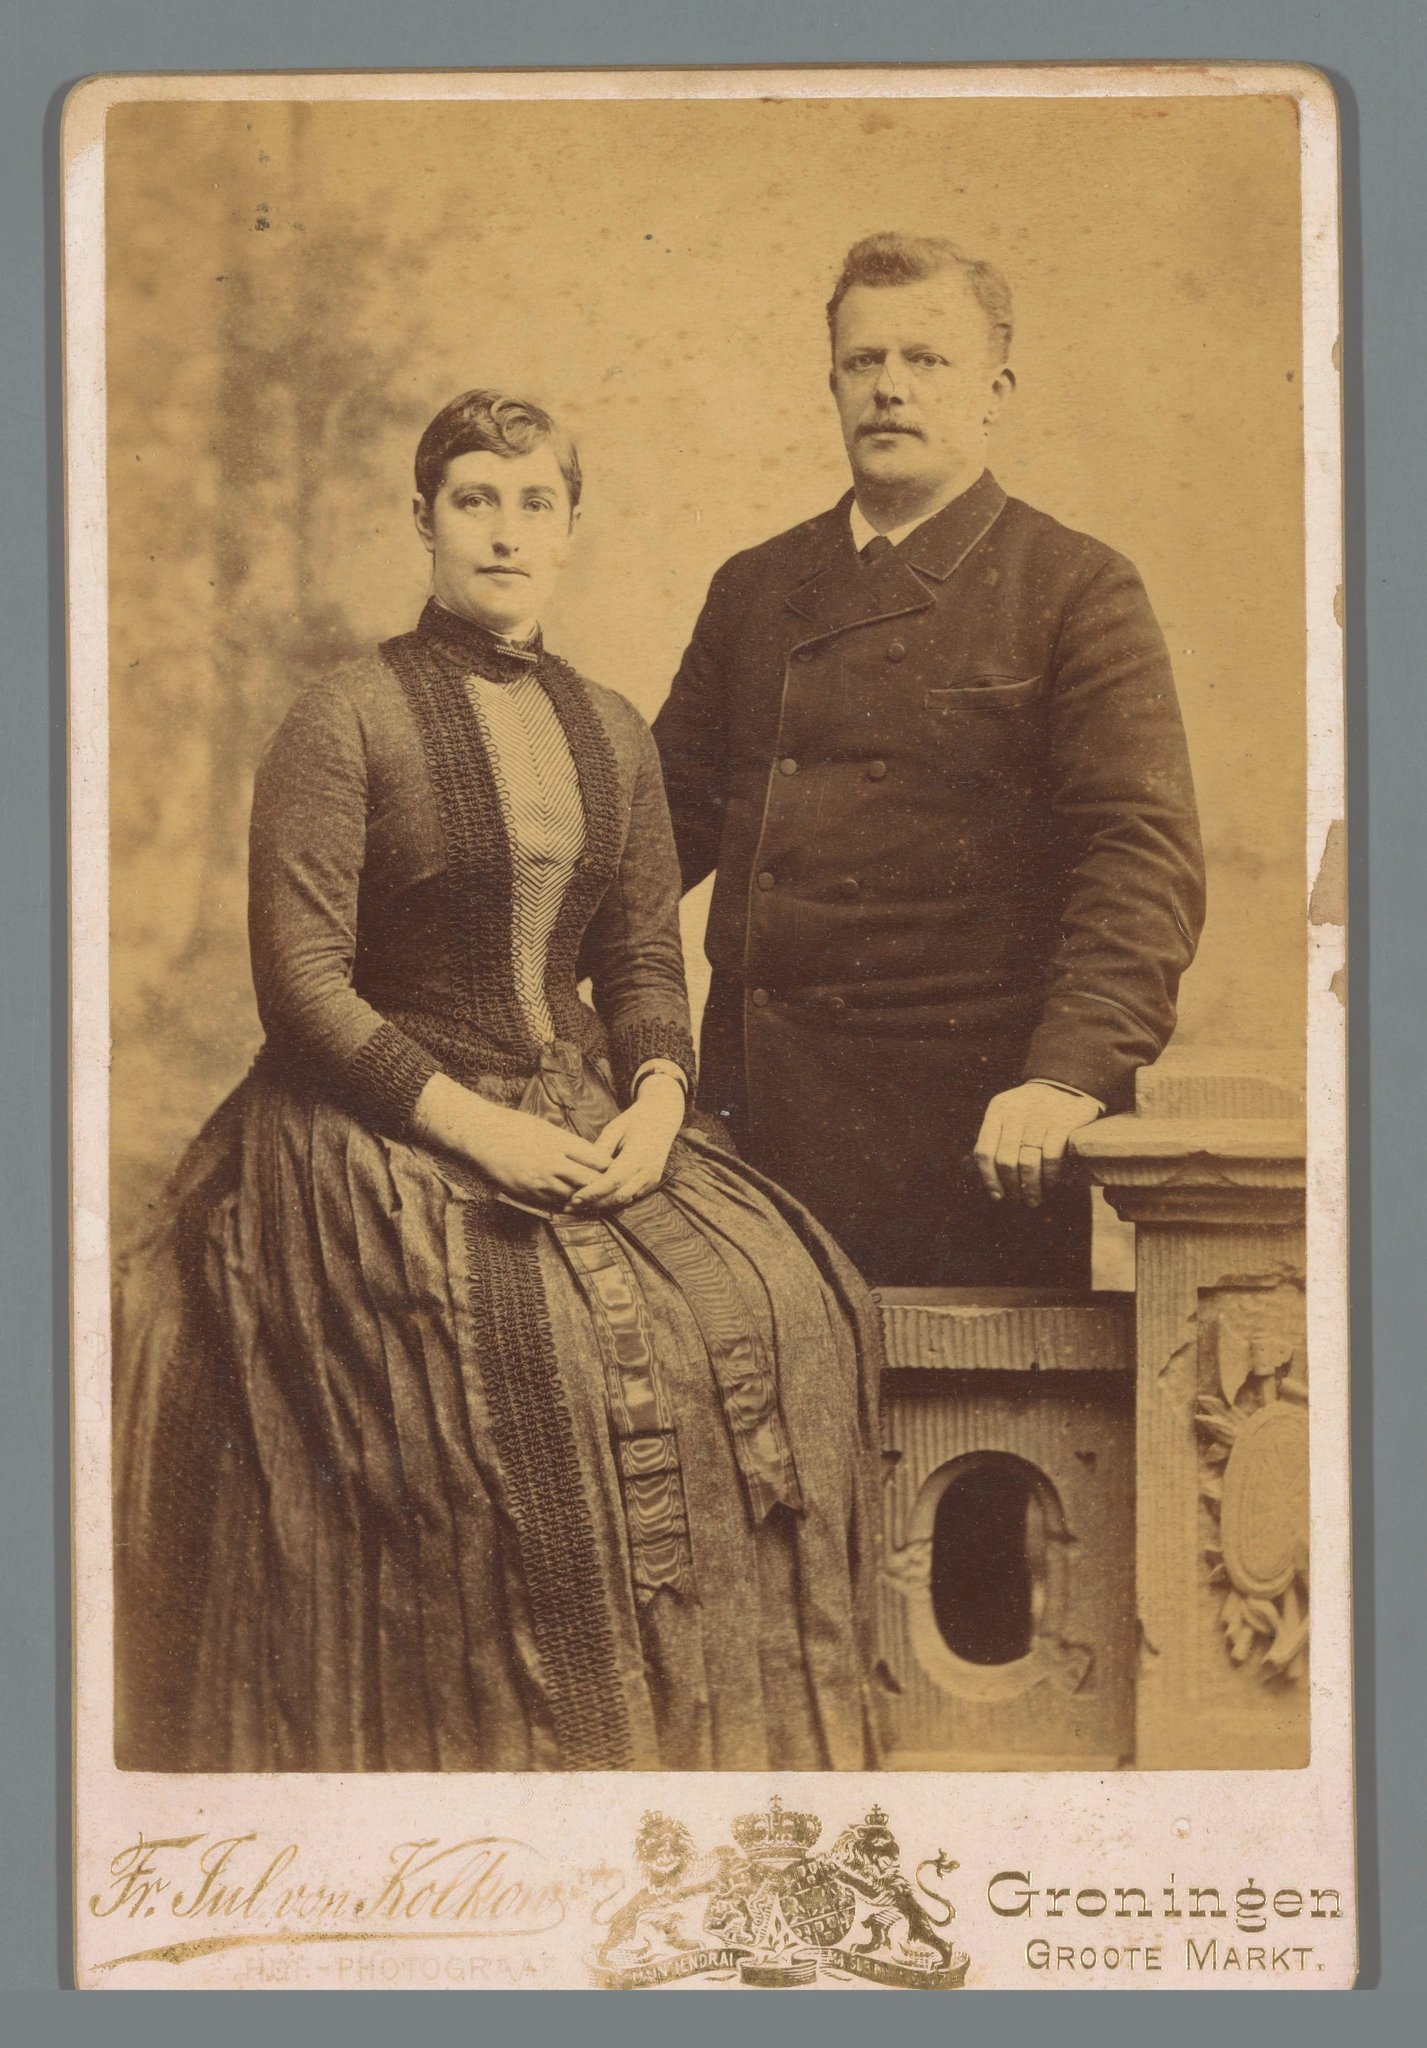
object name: cabinet photograph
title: Portret van een onbekende man en vrouw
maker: friedrich julius von kolkow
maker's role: fotograaf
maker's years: 1839-1914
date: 1864-1913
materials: cardboard, photographic support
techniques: albumen print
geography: groningen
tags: adult woman, studio requisites ~ photographer, adult man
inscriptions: name: ‘Fr. Jul. von Kolkow Hof-Photograaf Groningen Groote Markt.’